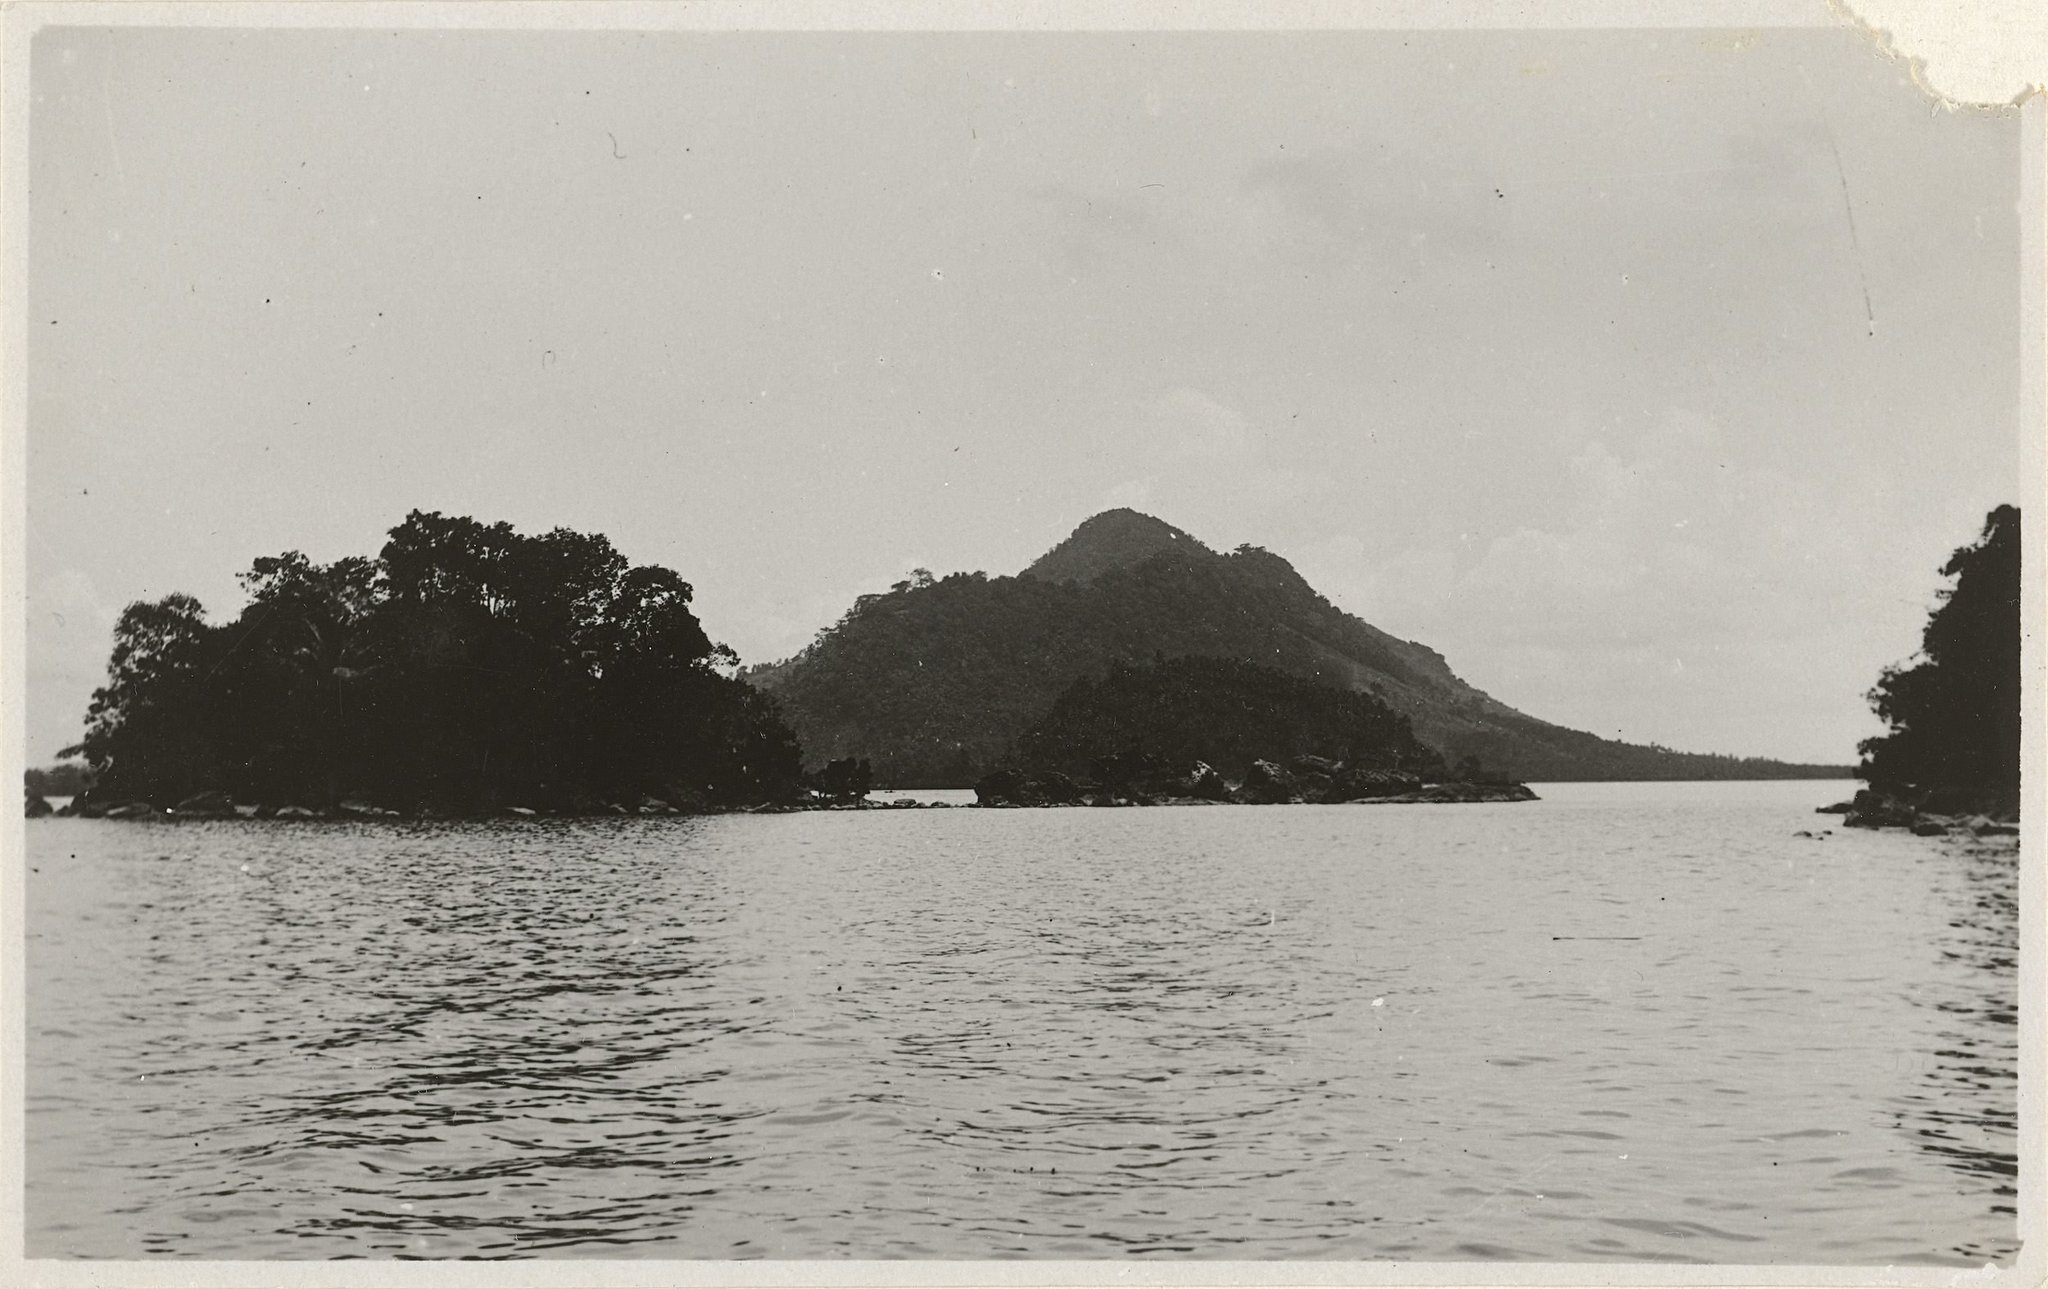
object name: photograph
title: Zicht op een berg gelegen in het water in Singkawang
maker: Anonymous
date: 1920-1940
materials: photographic support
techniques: gelatin silver print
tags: borneo